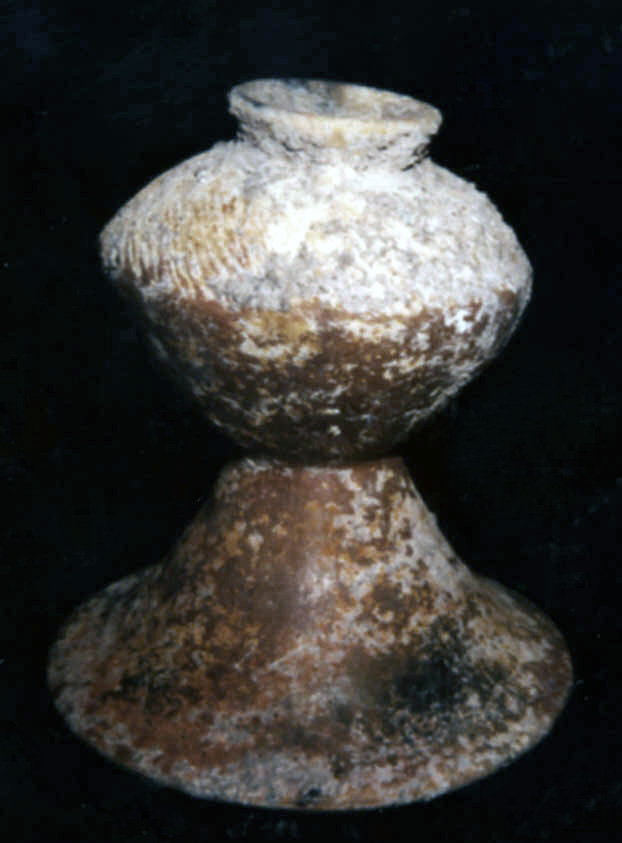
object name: vessel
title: Small Vessel with Globular Body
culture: thai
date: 500 BCE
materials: earthenware